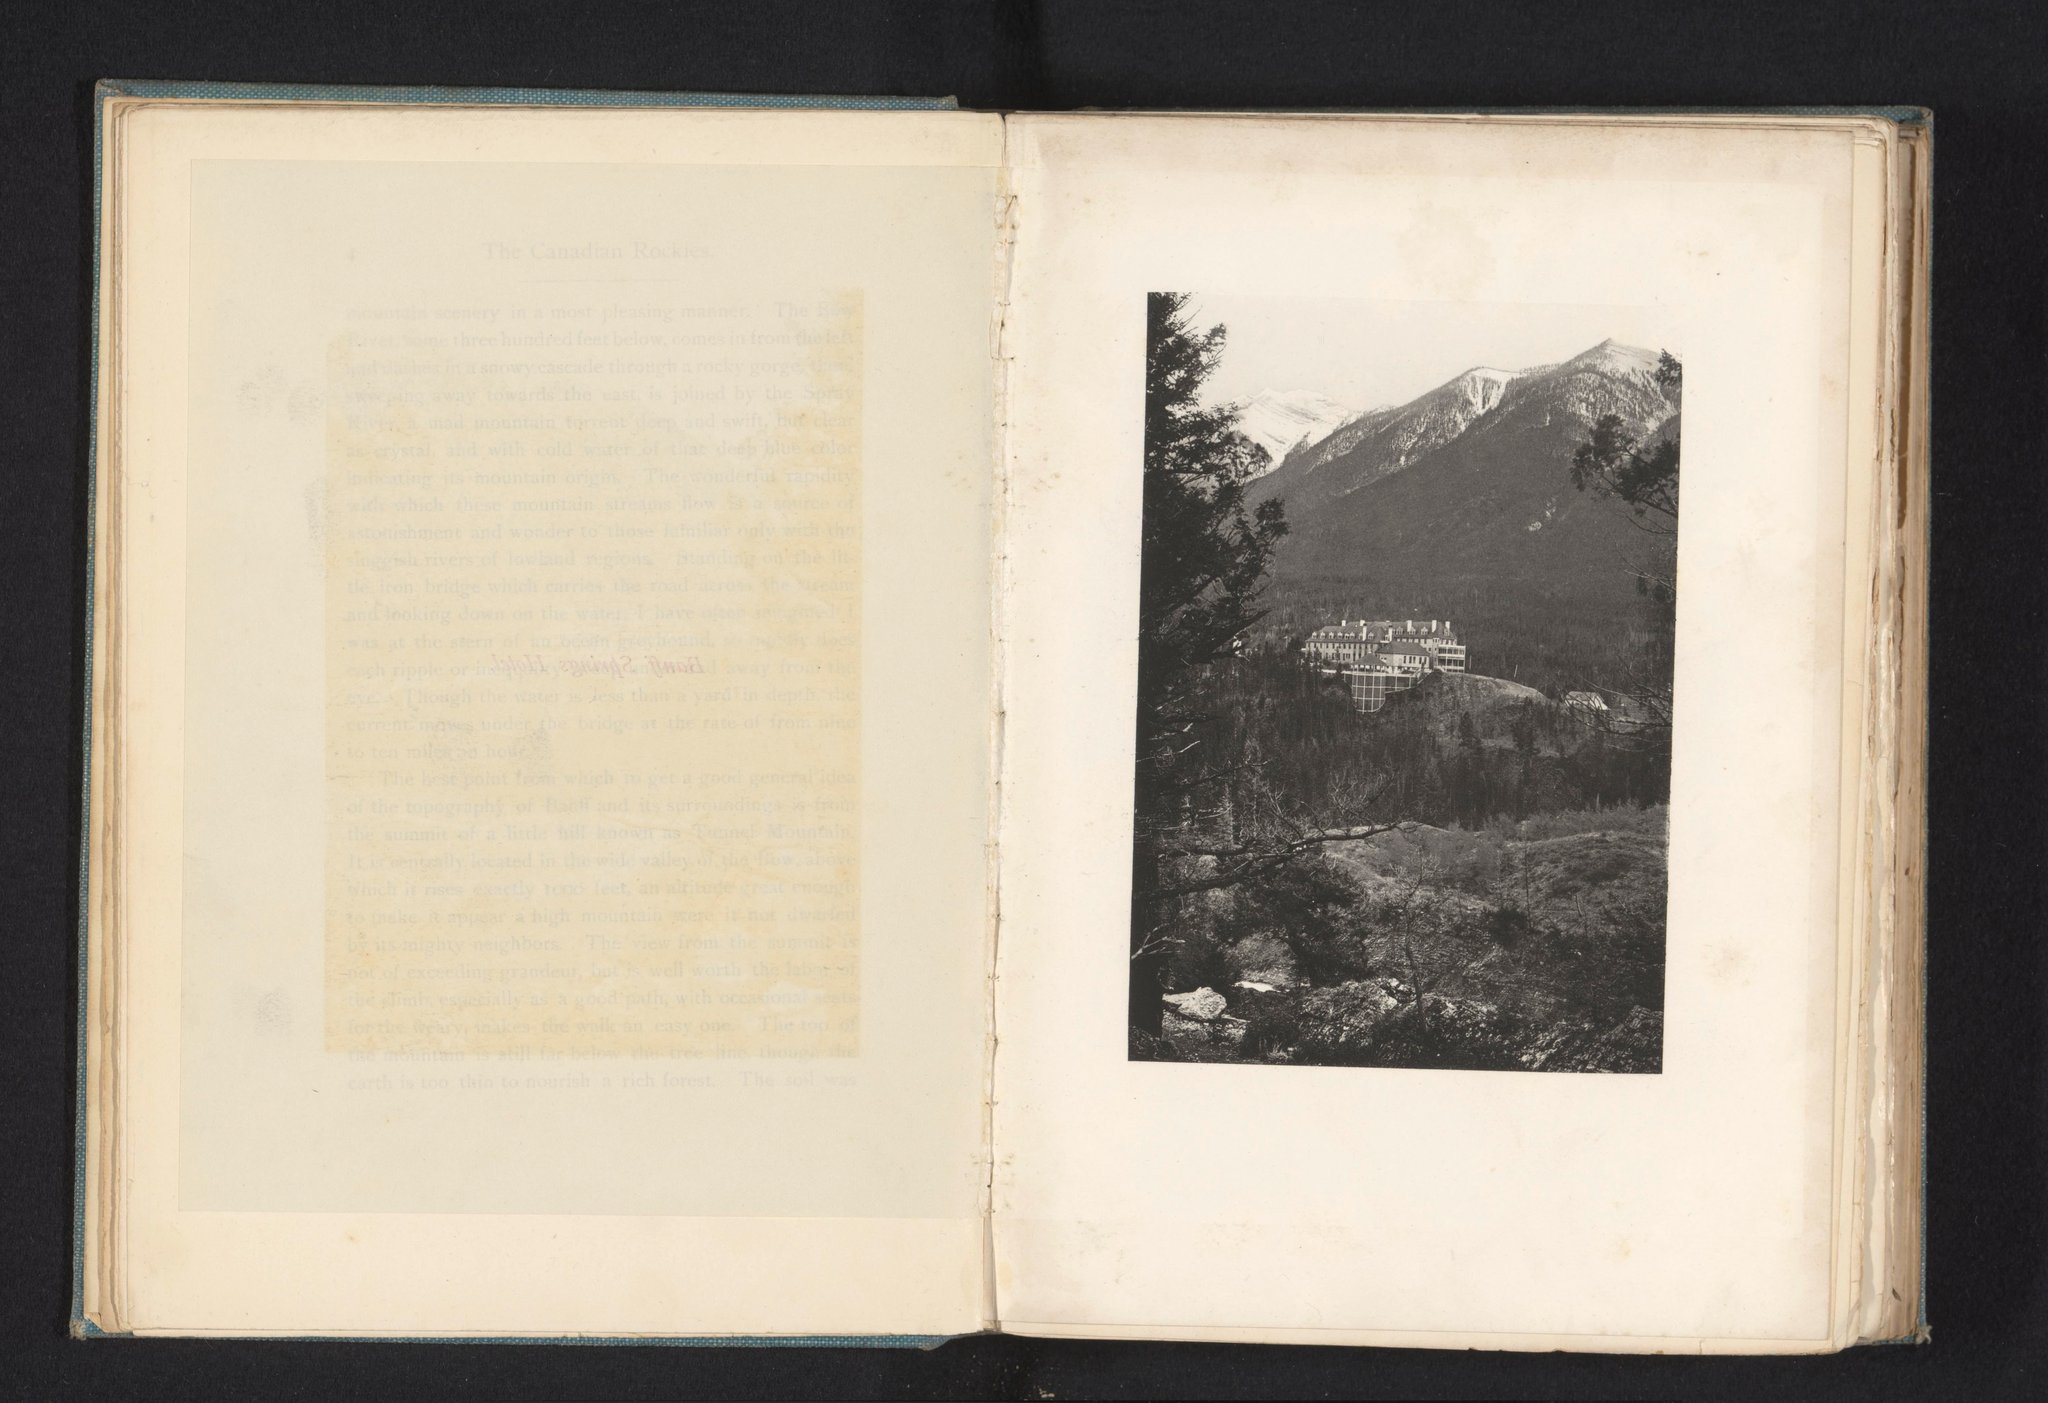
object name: photomechanical print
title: Gezicht op het Banff Springs Hotel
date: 1893-1897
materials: paper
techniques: photoaquatint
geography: canada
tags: façade (of house or building), hotel, hostelry, inn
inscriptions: title: ‘Banff Springs Hotel’